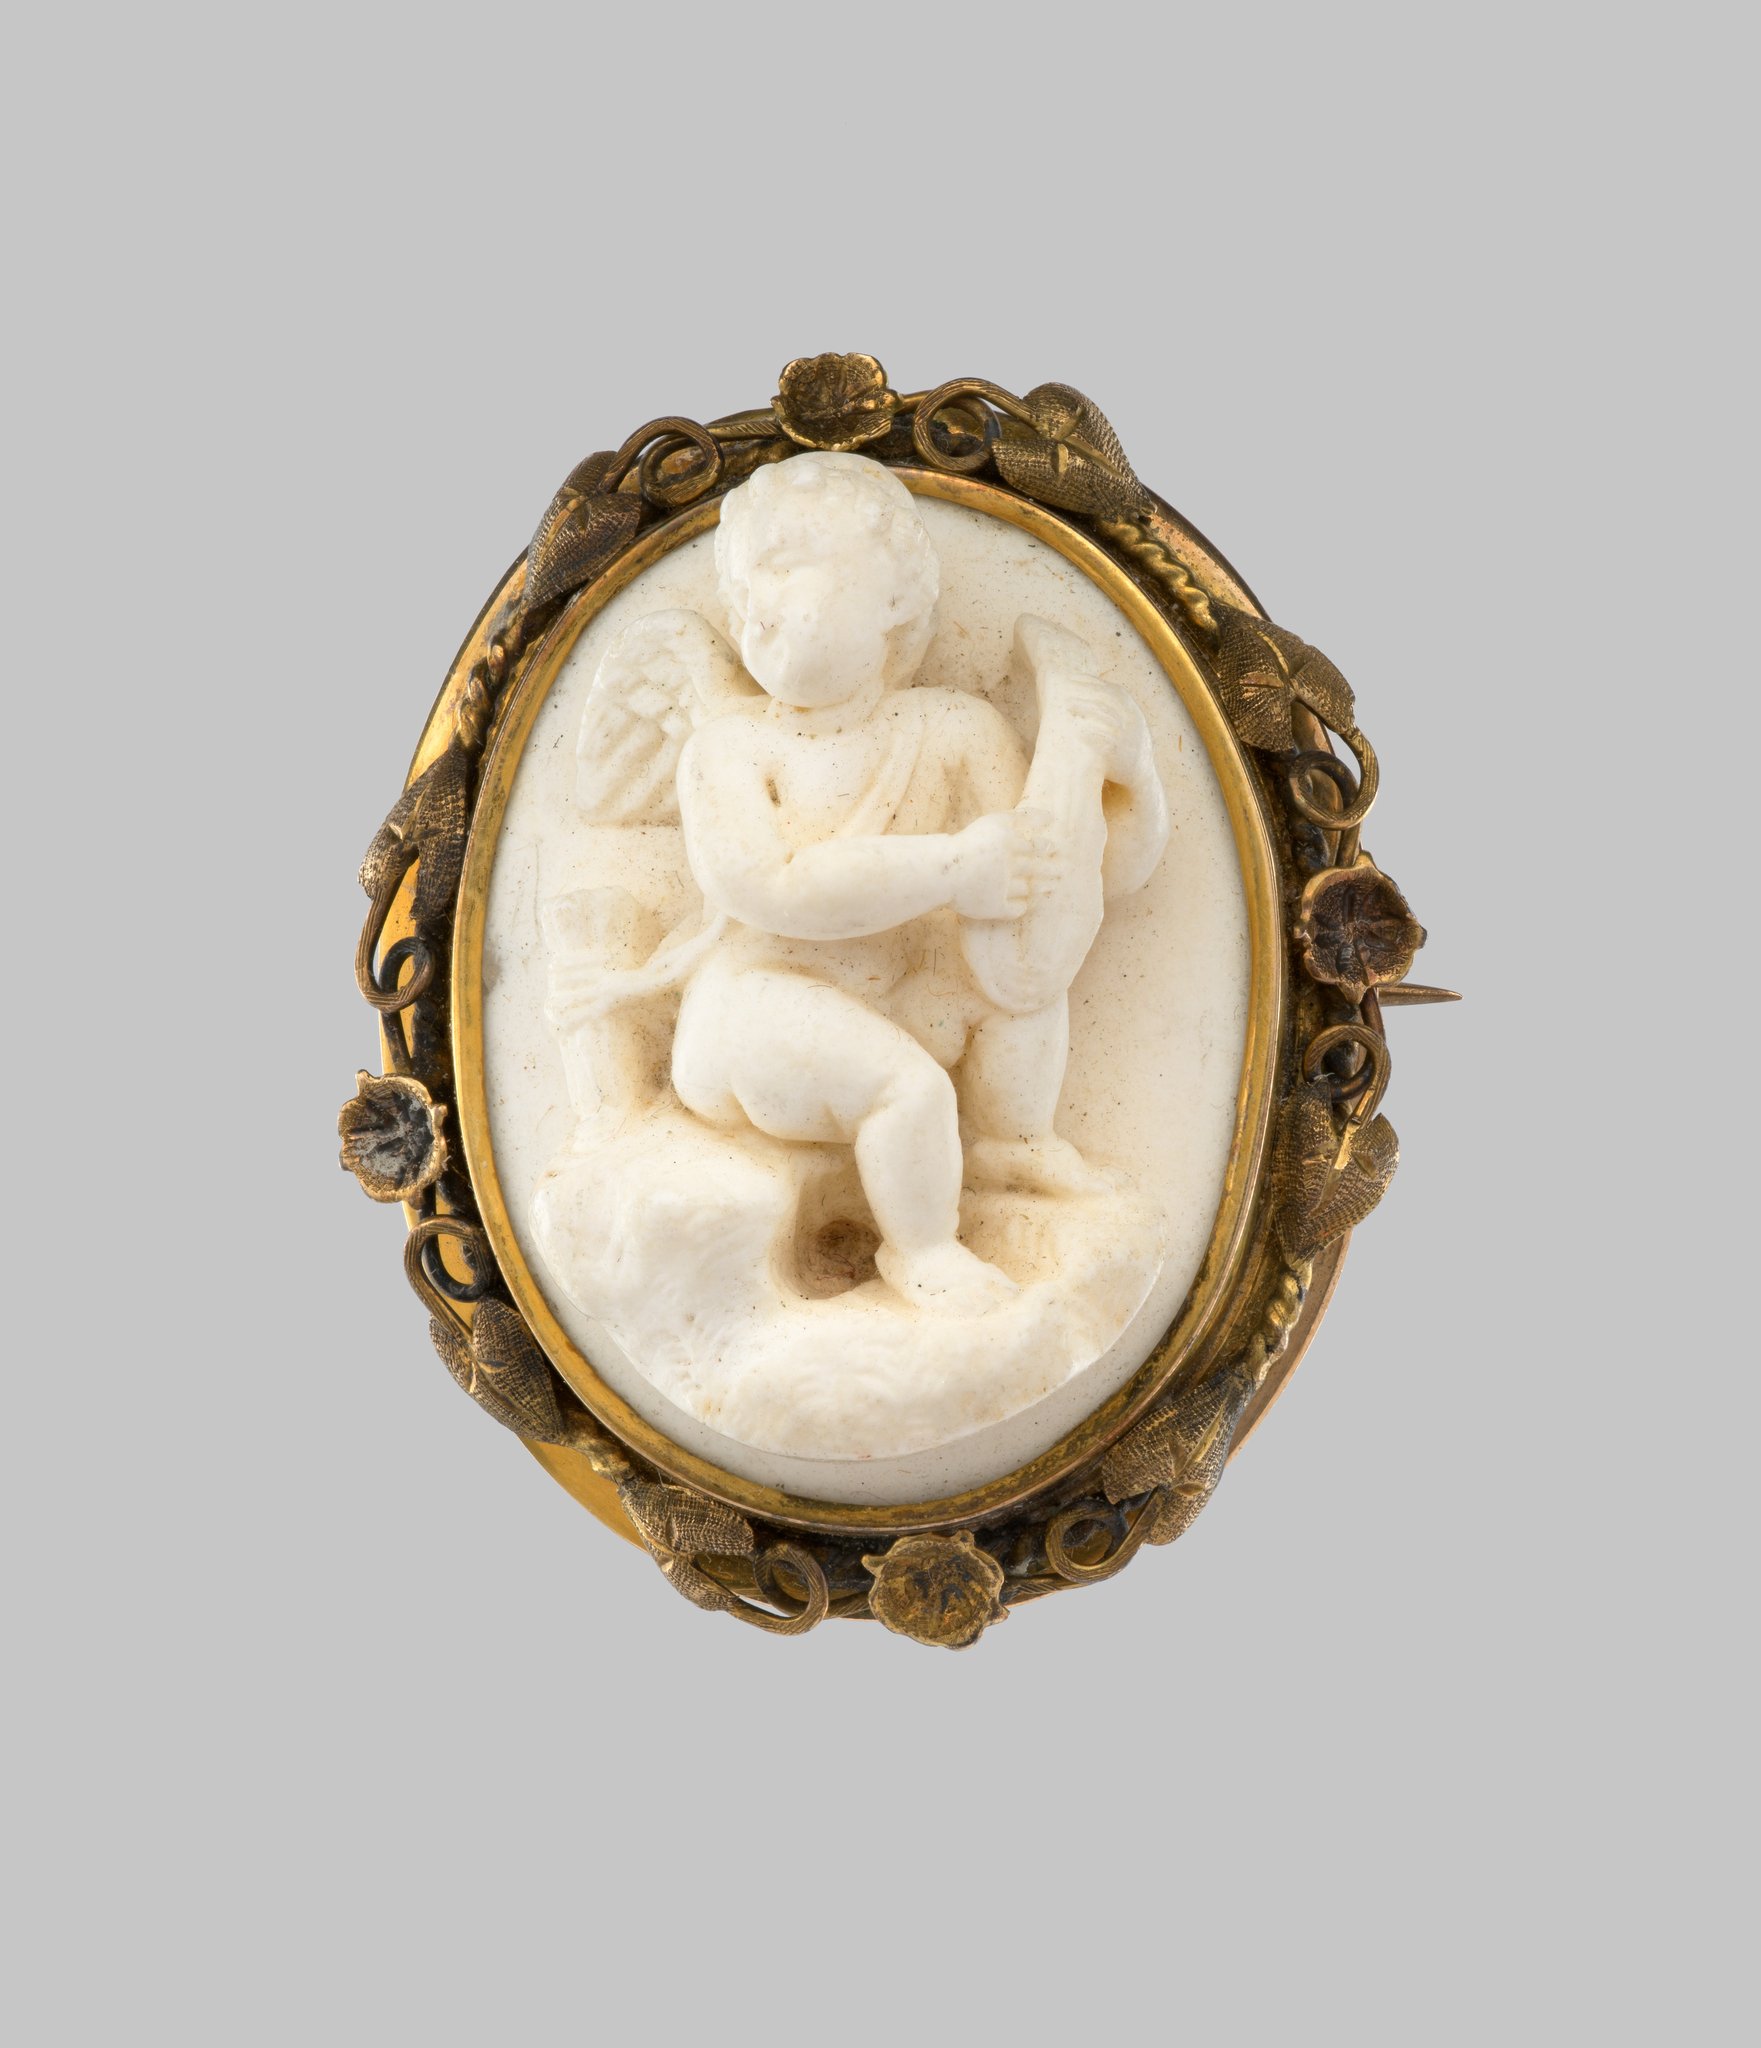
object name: earring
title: Earring (one of a pair) (part of parure)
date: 1840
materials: gold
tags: lutes,cupid